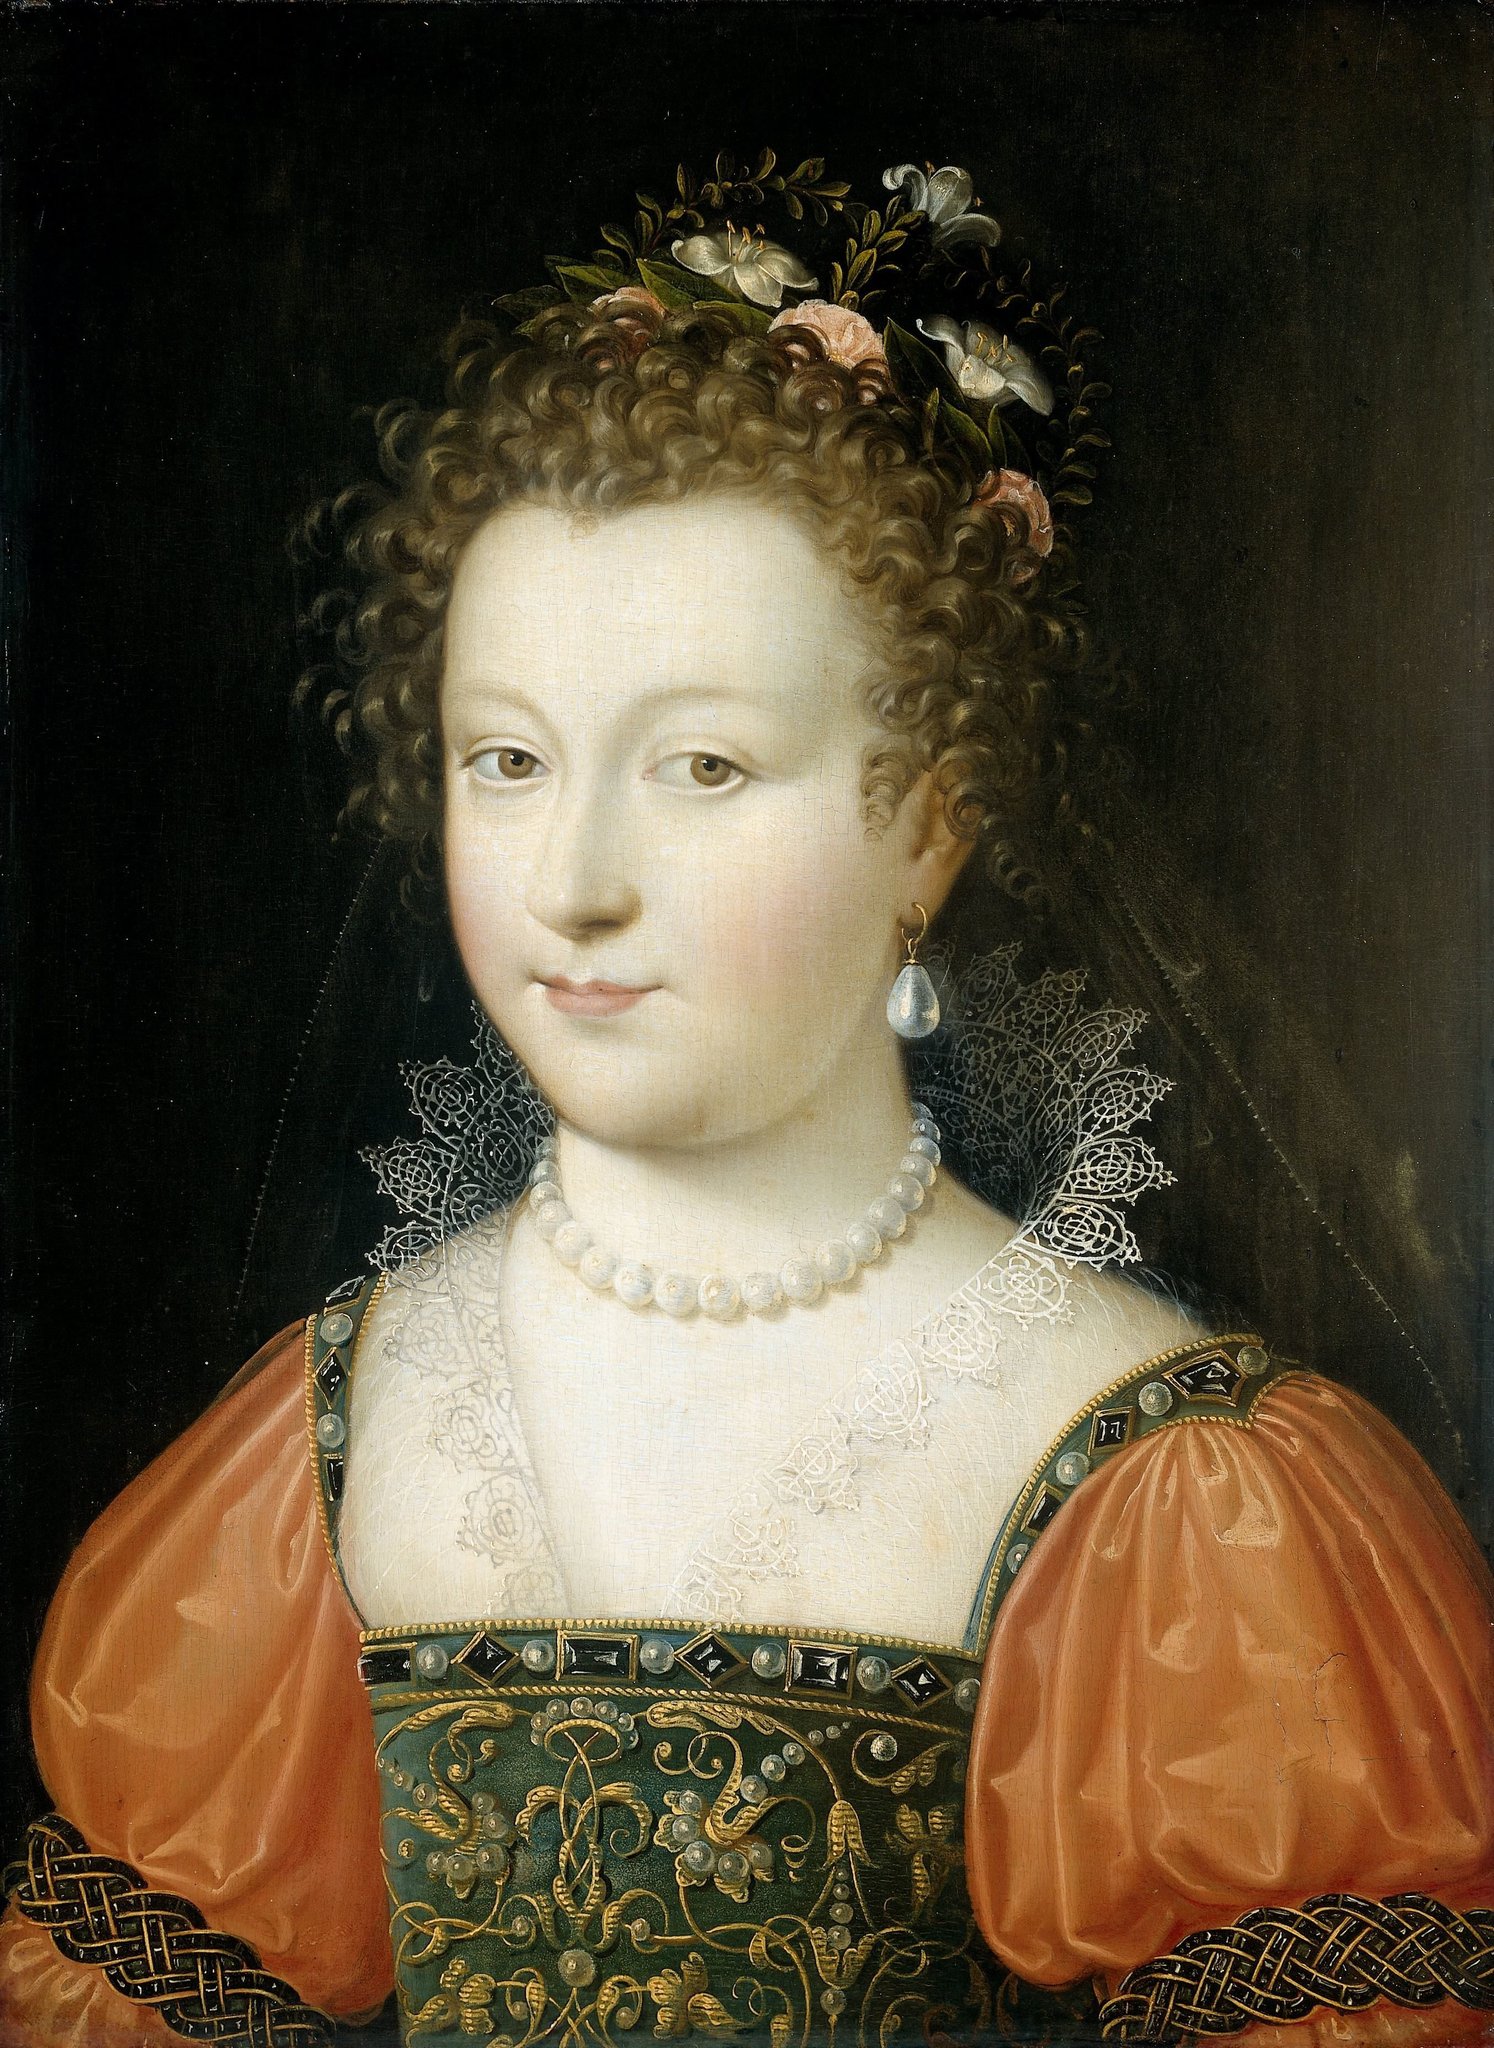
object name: painting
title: Portrait of a Woman (previously identified as Queen Elizabeth I)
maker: Anonymous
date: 1550-1574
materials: oil, panel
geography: fontainebleau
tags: historical persons not known by name - bb - woman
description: Portret van een vrouw. Vroeger geïdentificeerd als Elisabeth I (1533-1603), koningin van Engeland. Buste, iets naar links, met bloemen in het haar en een parelsnoer om de hals.